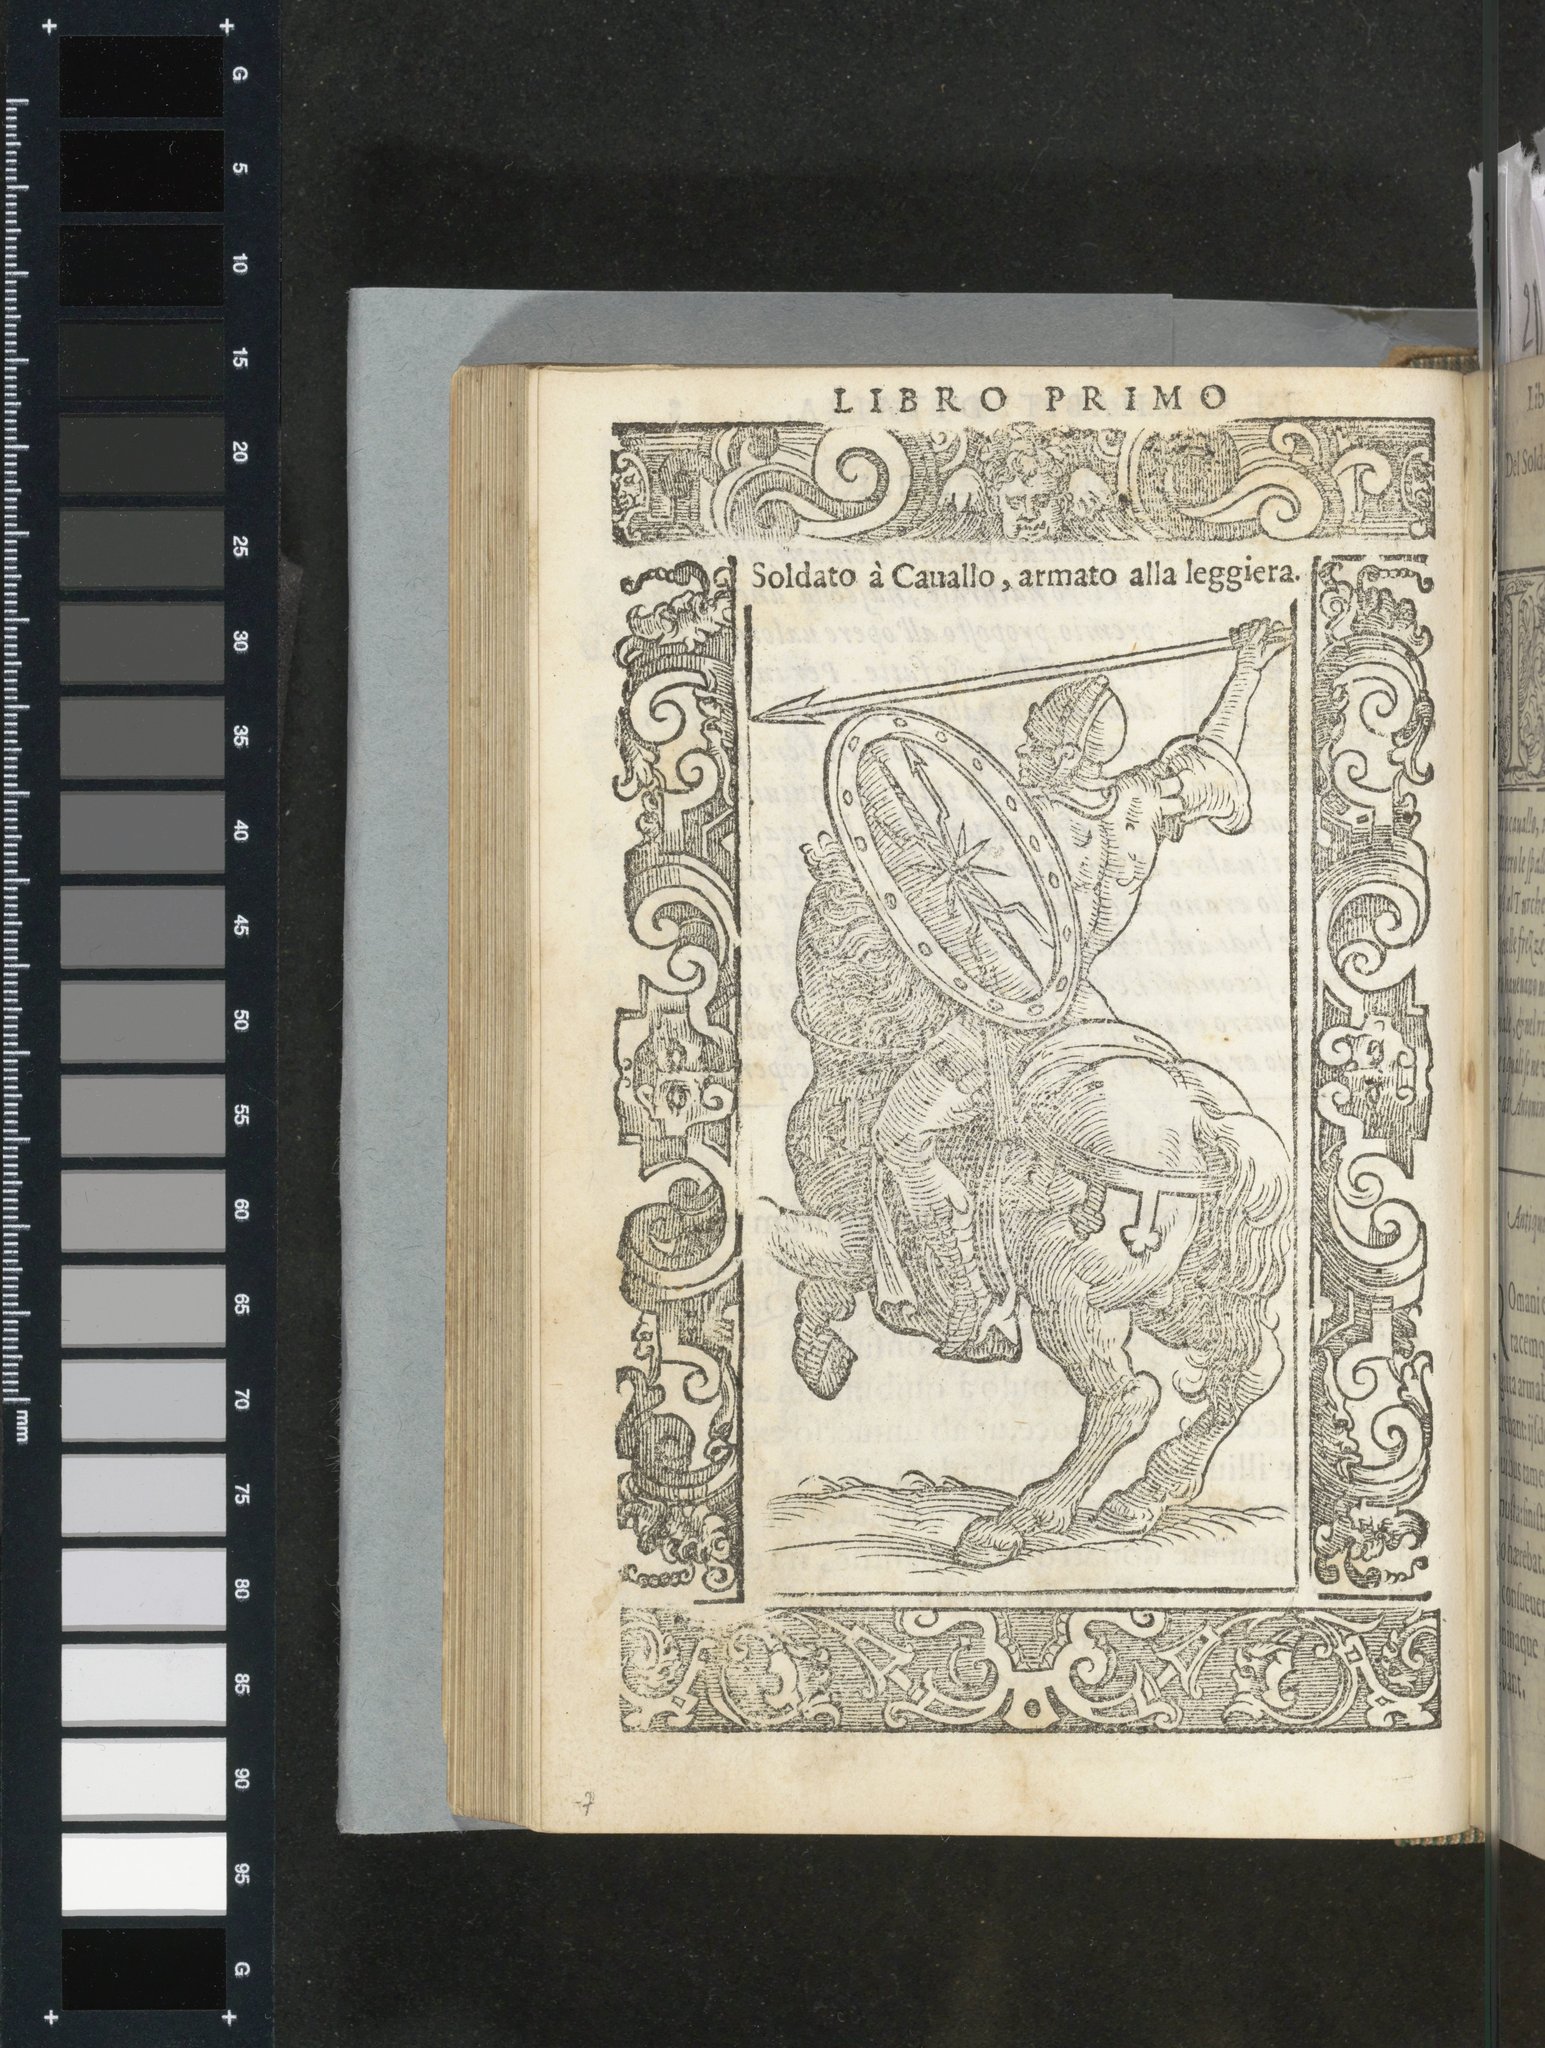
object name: costume print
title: Habiti antichi, et moderni di tutto il mondo : di nuovo accresciuti di molte figure : vestitus antiquorum, recentiorumque totius orbis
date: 1598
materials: paper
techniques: woodcut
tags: private soldier (+ cavalry, horsemen)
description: Soldaat te paard, naar links. met lans en schild. In ornamentrand.